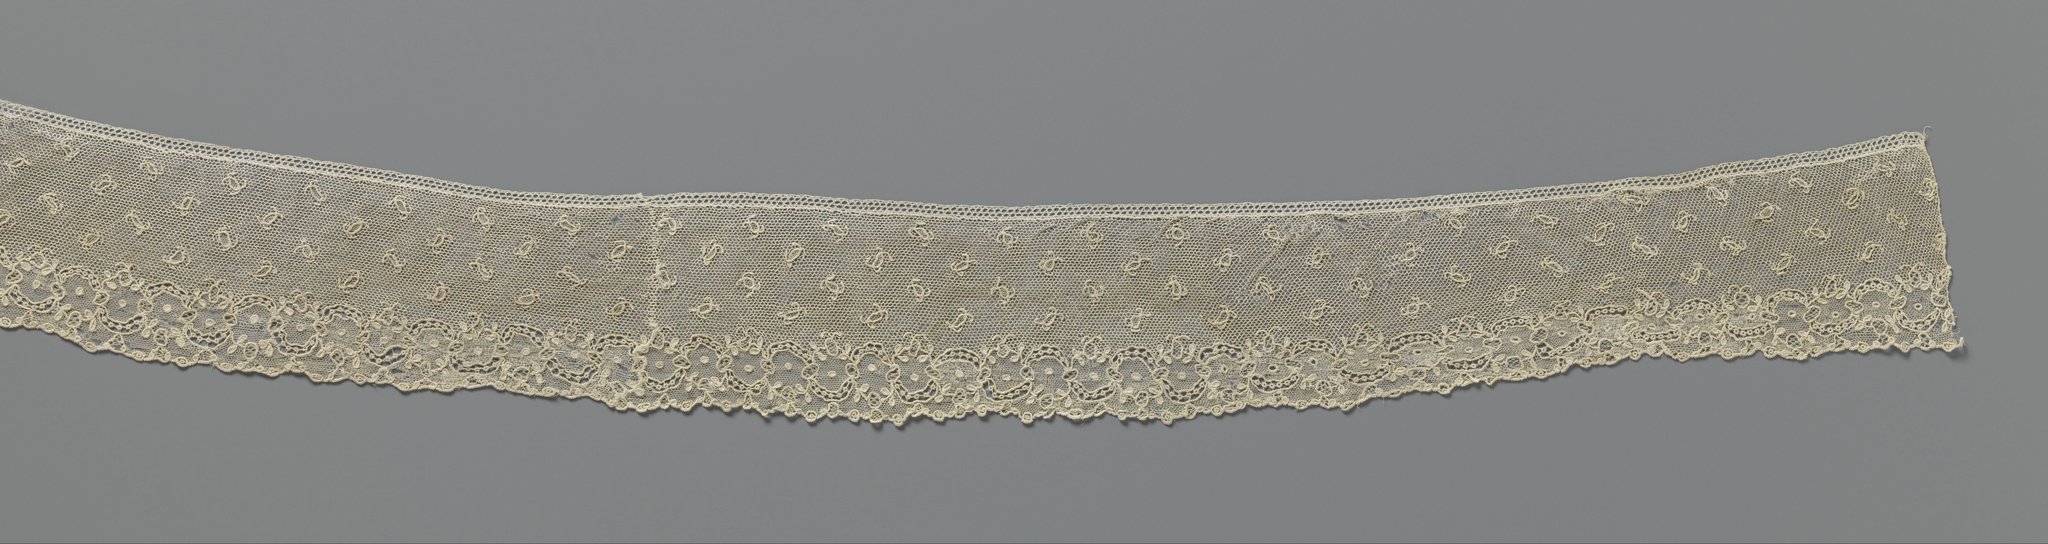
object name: strip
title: Strook naaldkant met in elkaar hakende boogjes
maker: Anonymous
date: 1775-1795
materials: linen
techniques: lace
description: Strook naturelkleurige naaldkant: Alençon-kant. Strooipatroon van in elkaar hakende boogjes, op een fijne zeshoekige maasgrond. Het patroon aan de onderzijde bestaat uit een aaneengeschakelde rij medaillons op een nog fijnere zeshoekige maasgrond. In het centrum van elk medaillon zit een gaatje met een cirkelvormig kordon. De bovenzijde is afgezet met een rand kloskant. Gepicoteerde onderrand met op regelmatige afstand raderpicots.